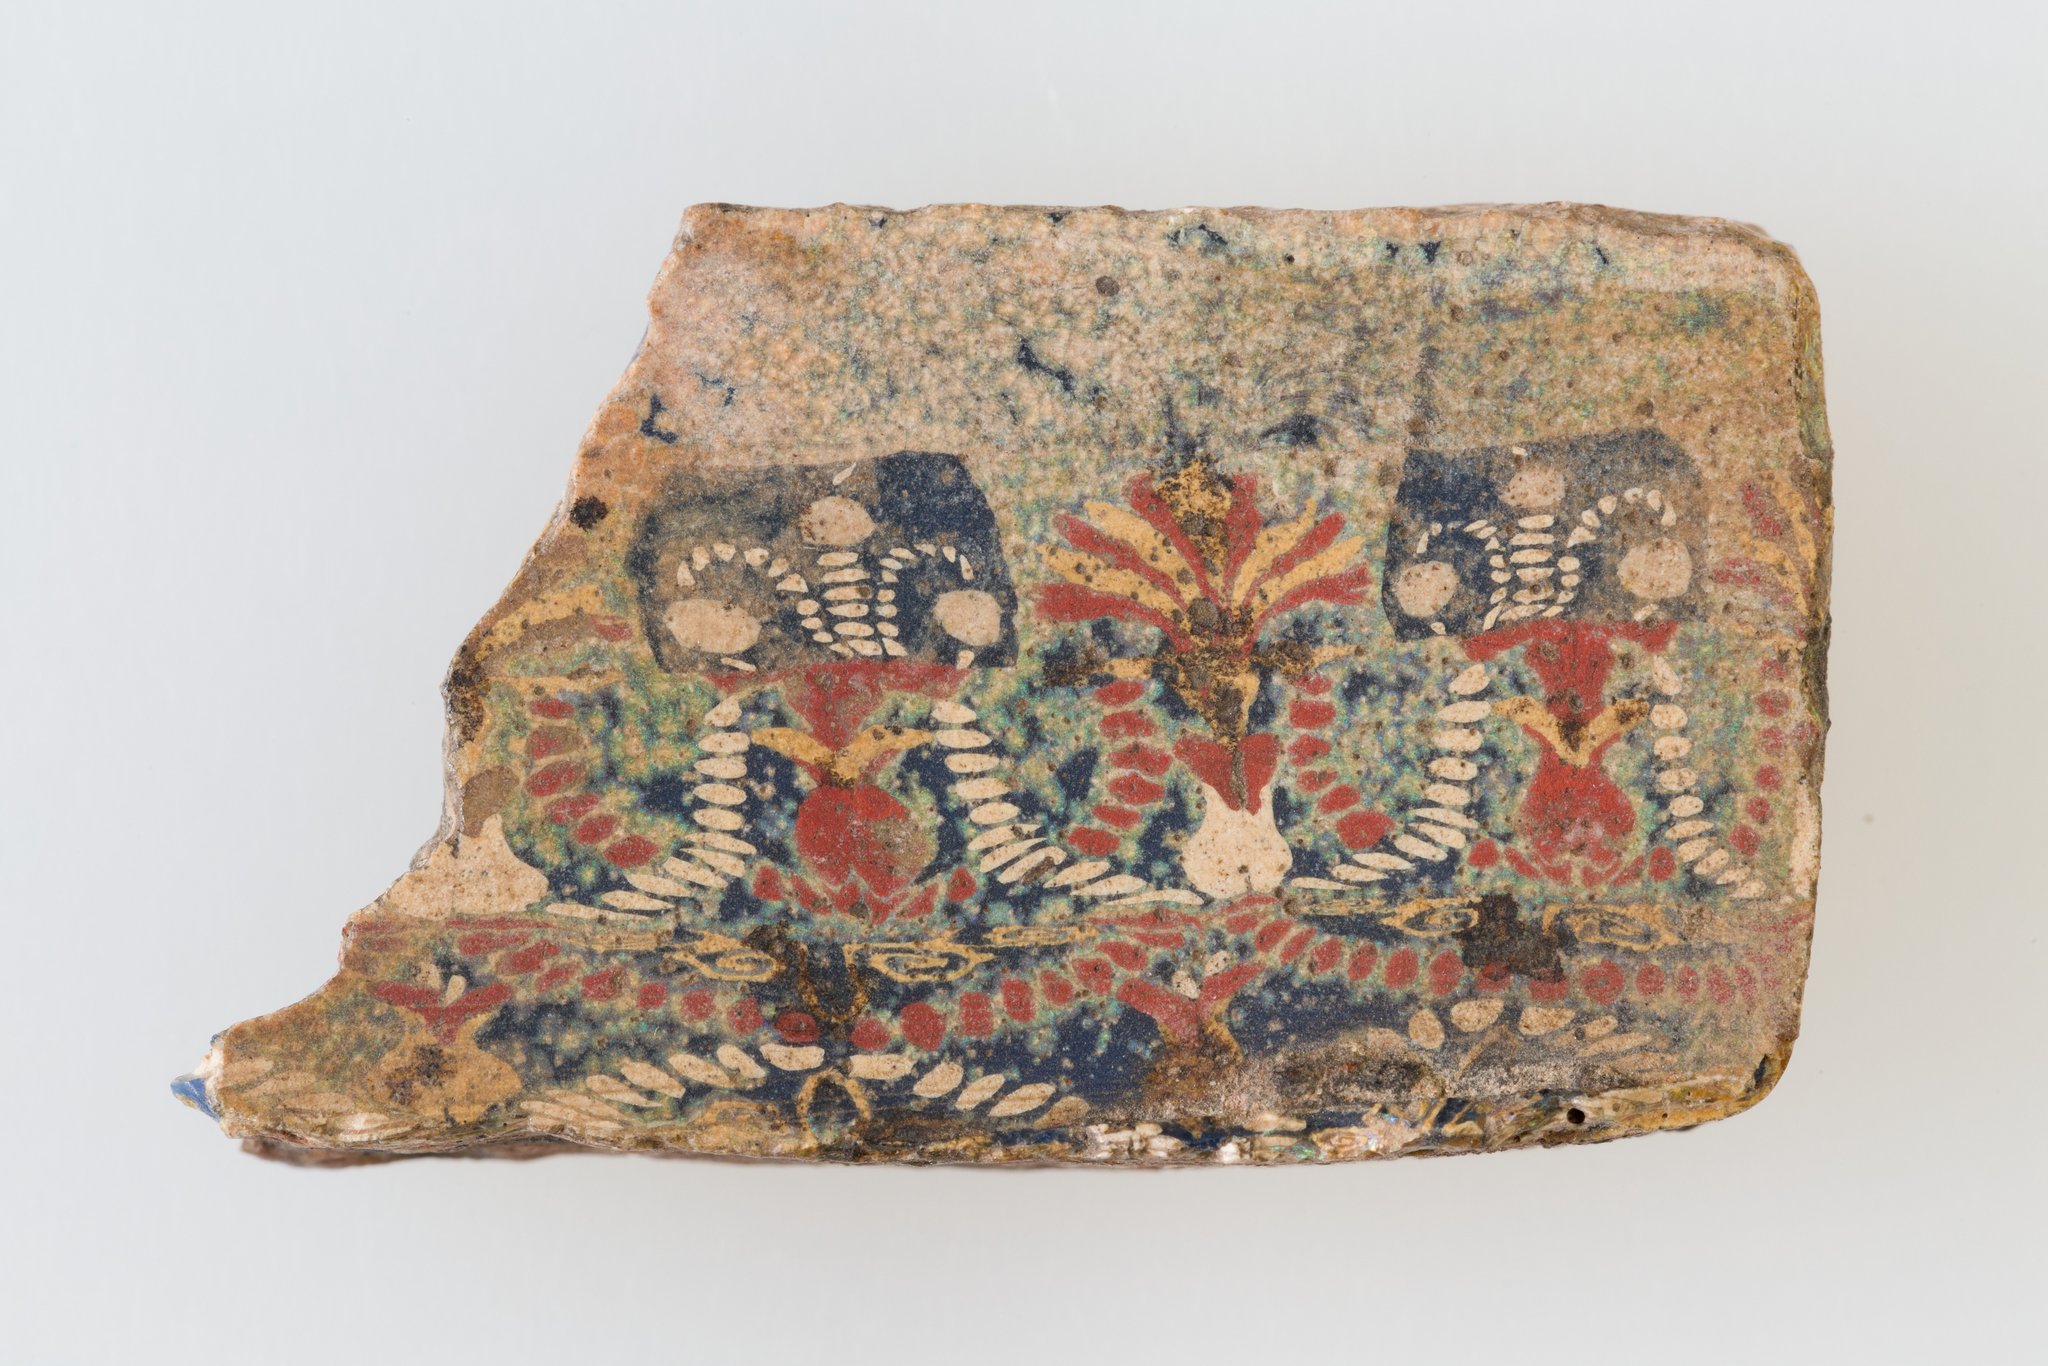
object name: inlay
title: Inlay, floral?, sema-tawy?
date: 100 BCE-100 CE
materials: glass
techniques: polychrome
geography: egypt